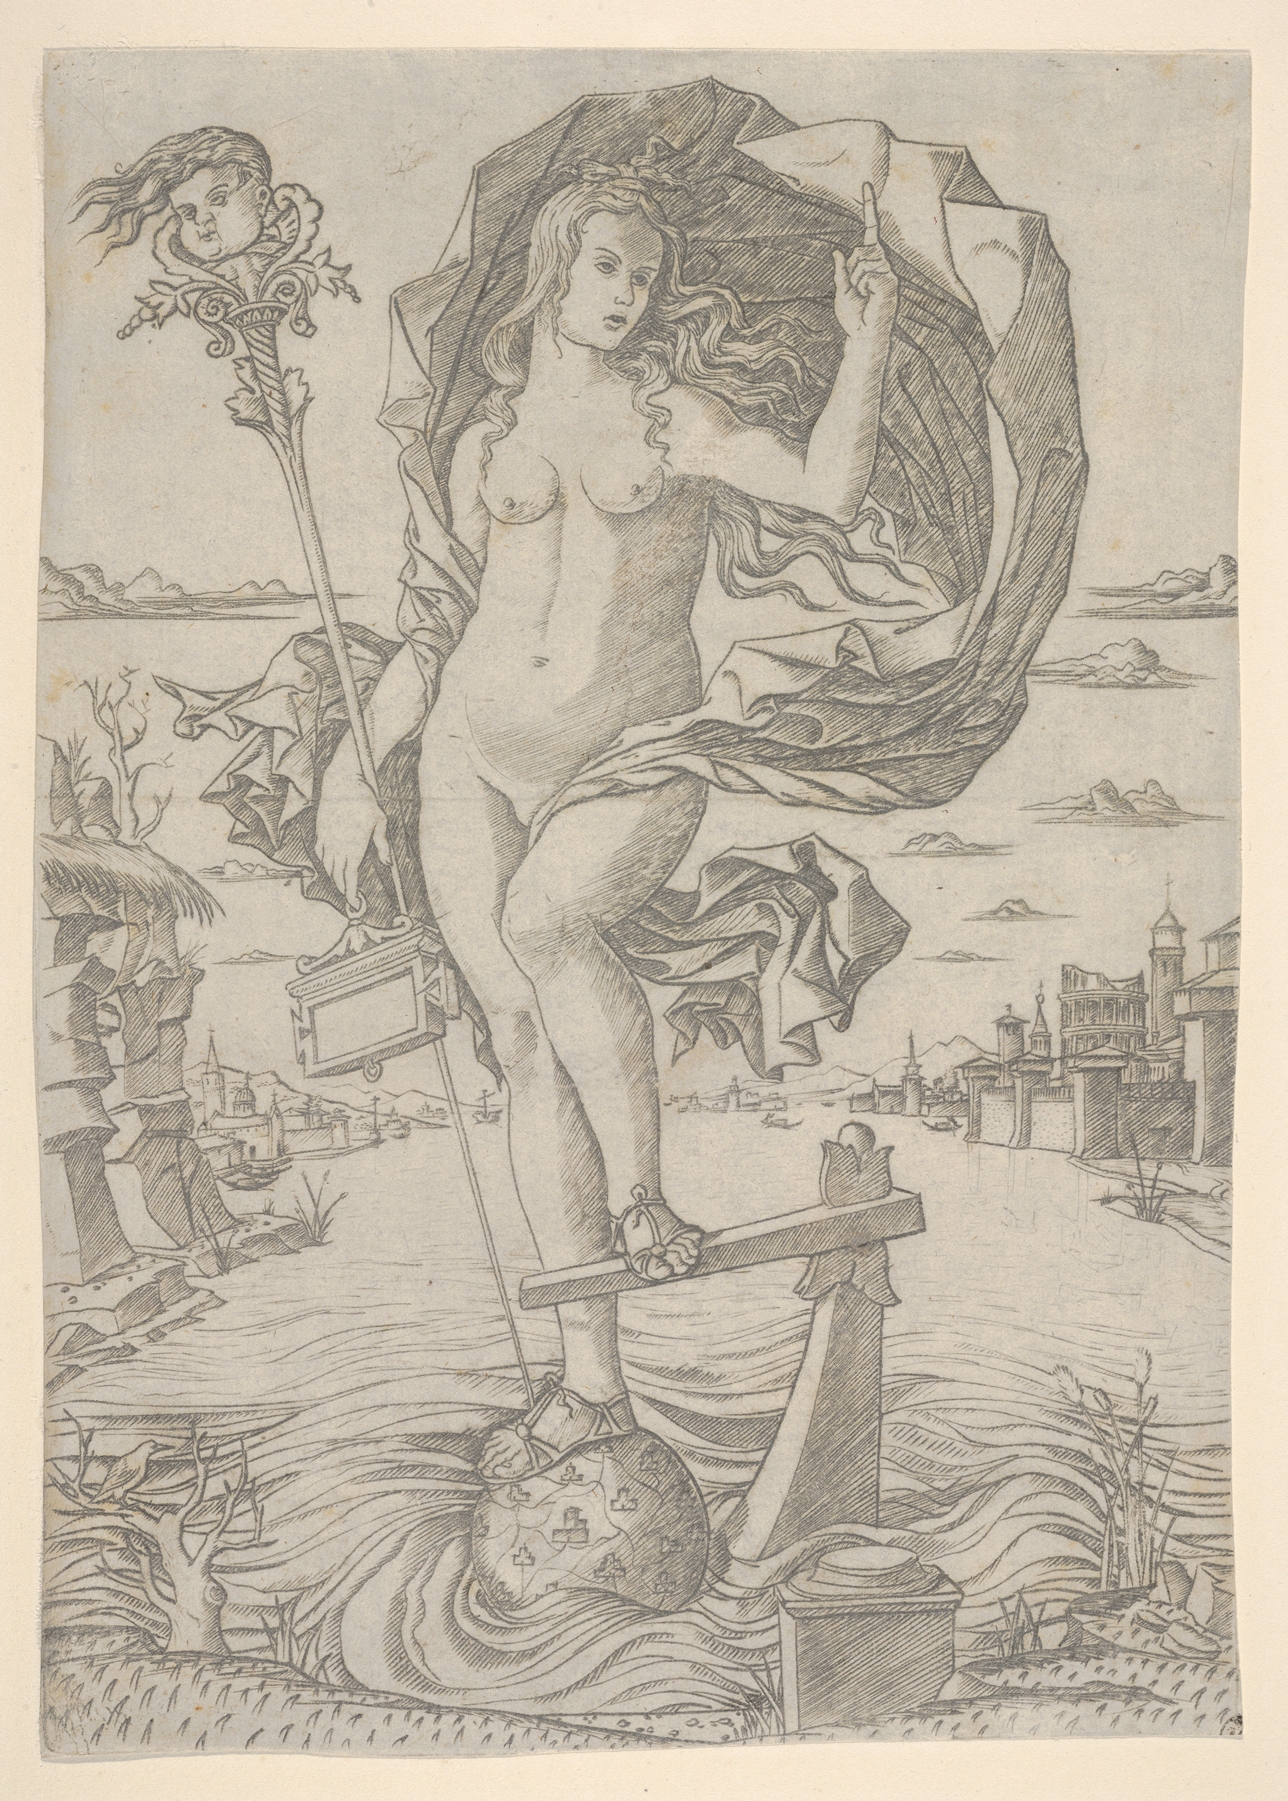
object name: print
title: A naked female figure representing Fortune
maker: nicoletto da modena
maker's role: artist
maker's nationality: italian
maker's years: 1500-1520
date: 1500-1510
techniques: engraving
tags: female nudes